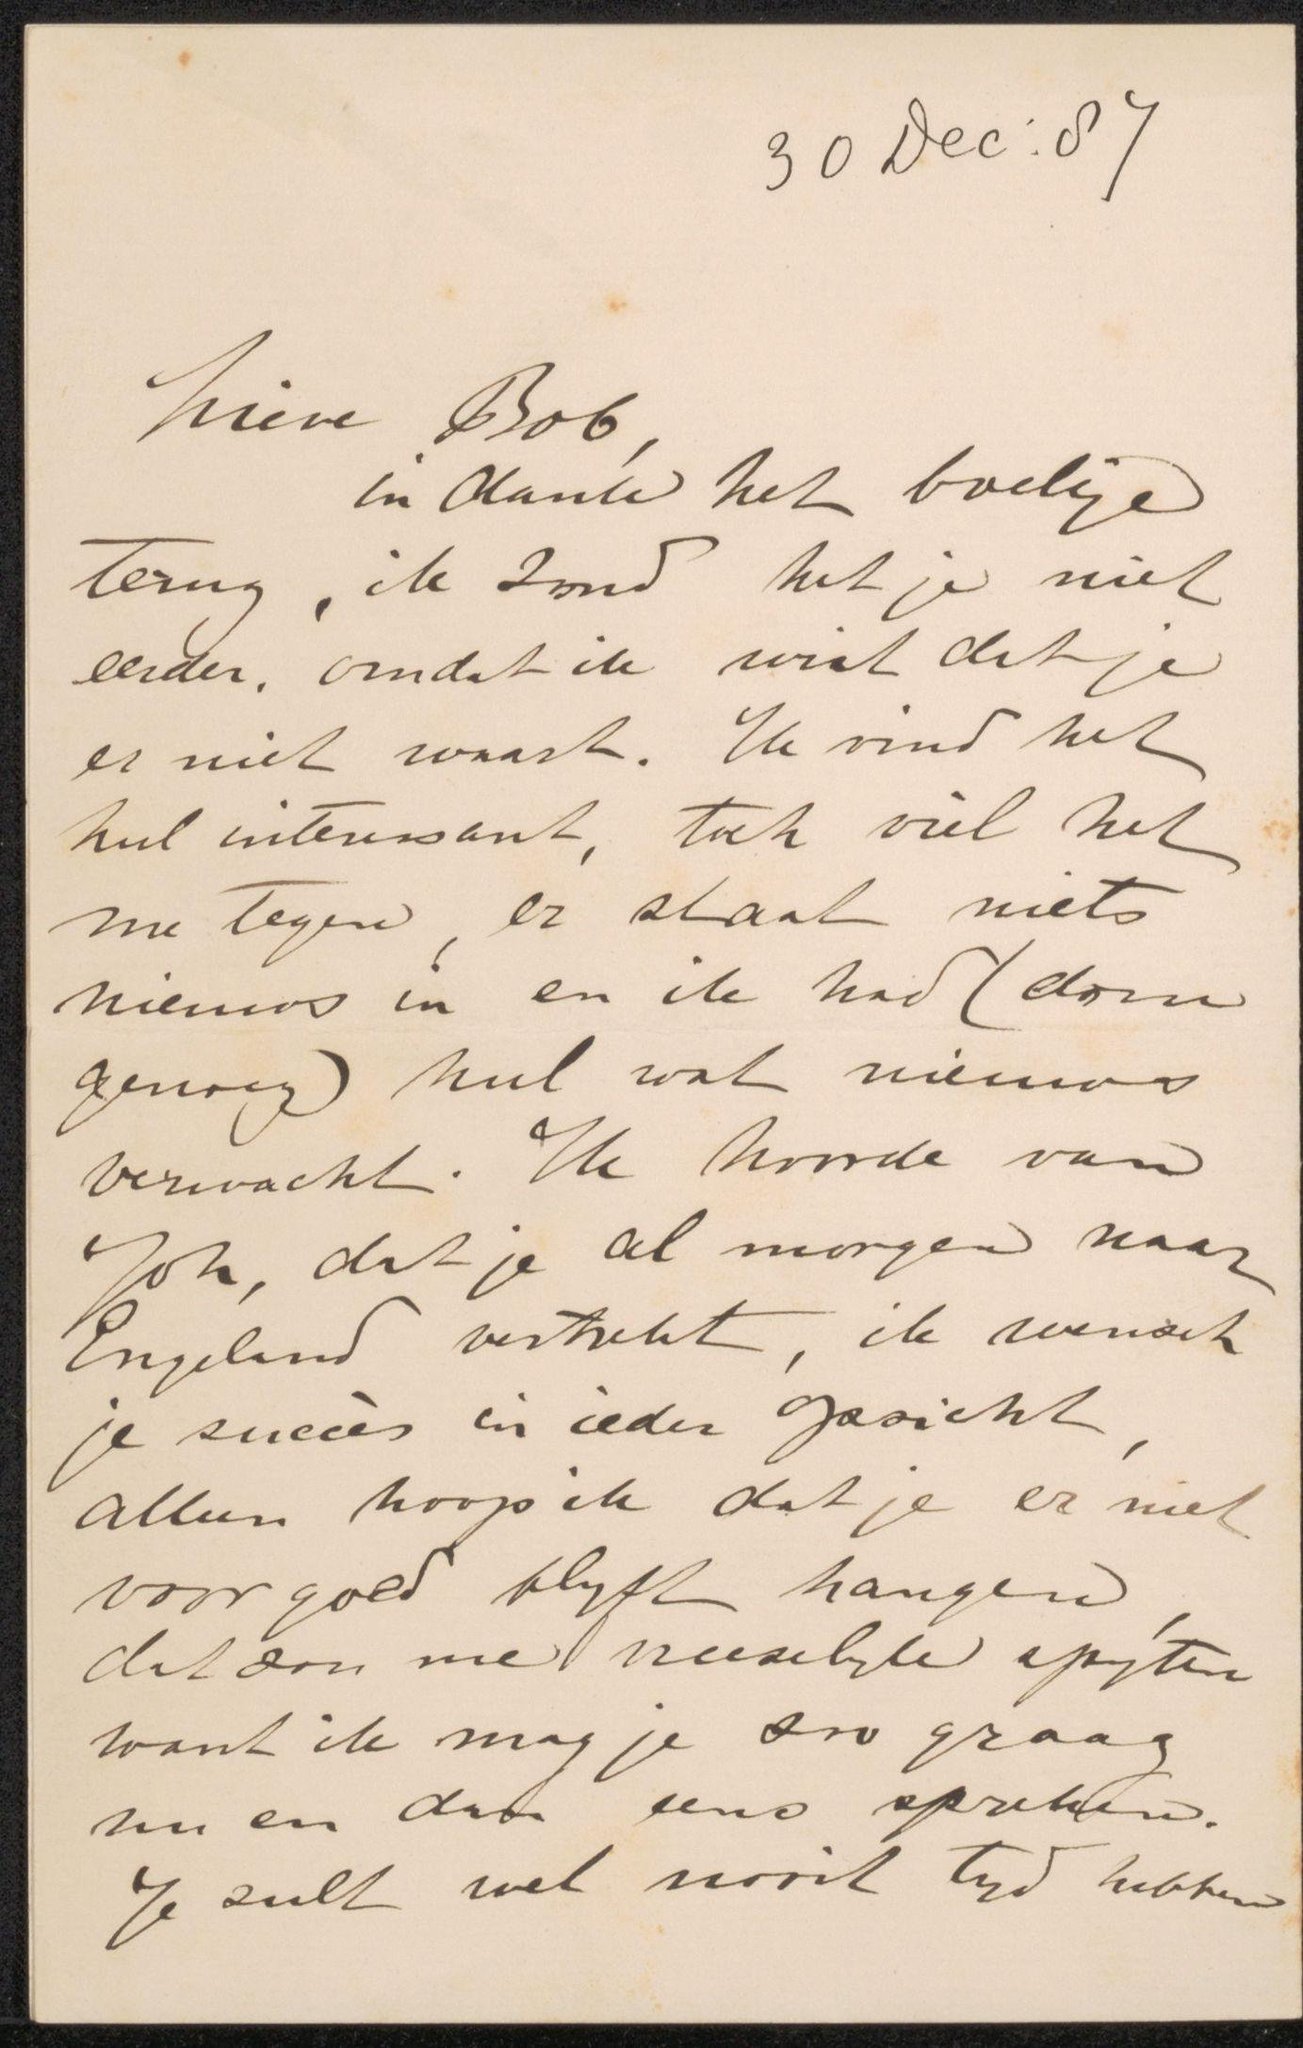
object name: letter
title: Brief aan Jan Veth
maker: wally moes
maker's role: draughtsman, print maker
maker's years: 1856-1918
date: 1874-1918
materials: ink, paper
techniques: pen, writing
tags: dordrecht, painter, designer, jan veth, printed matter, england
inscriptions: collector's mark: ‘RPK’